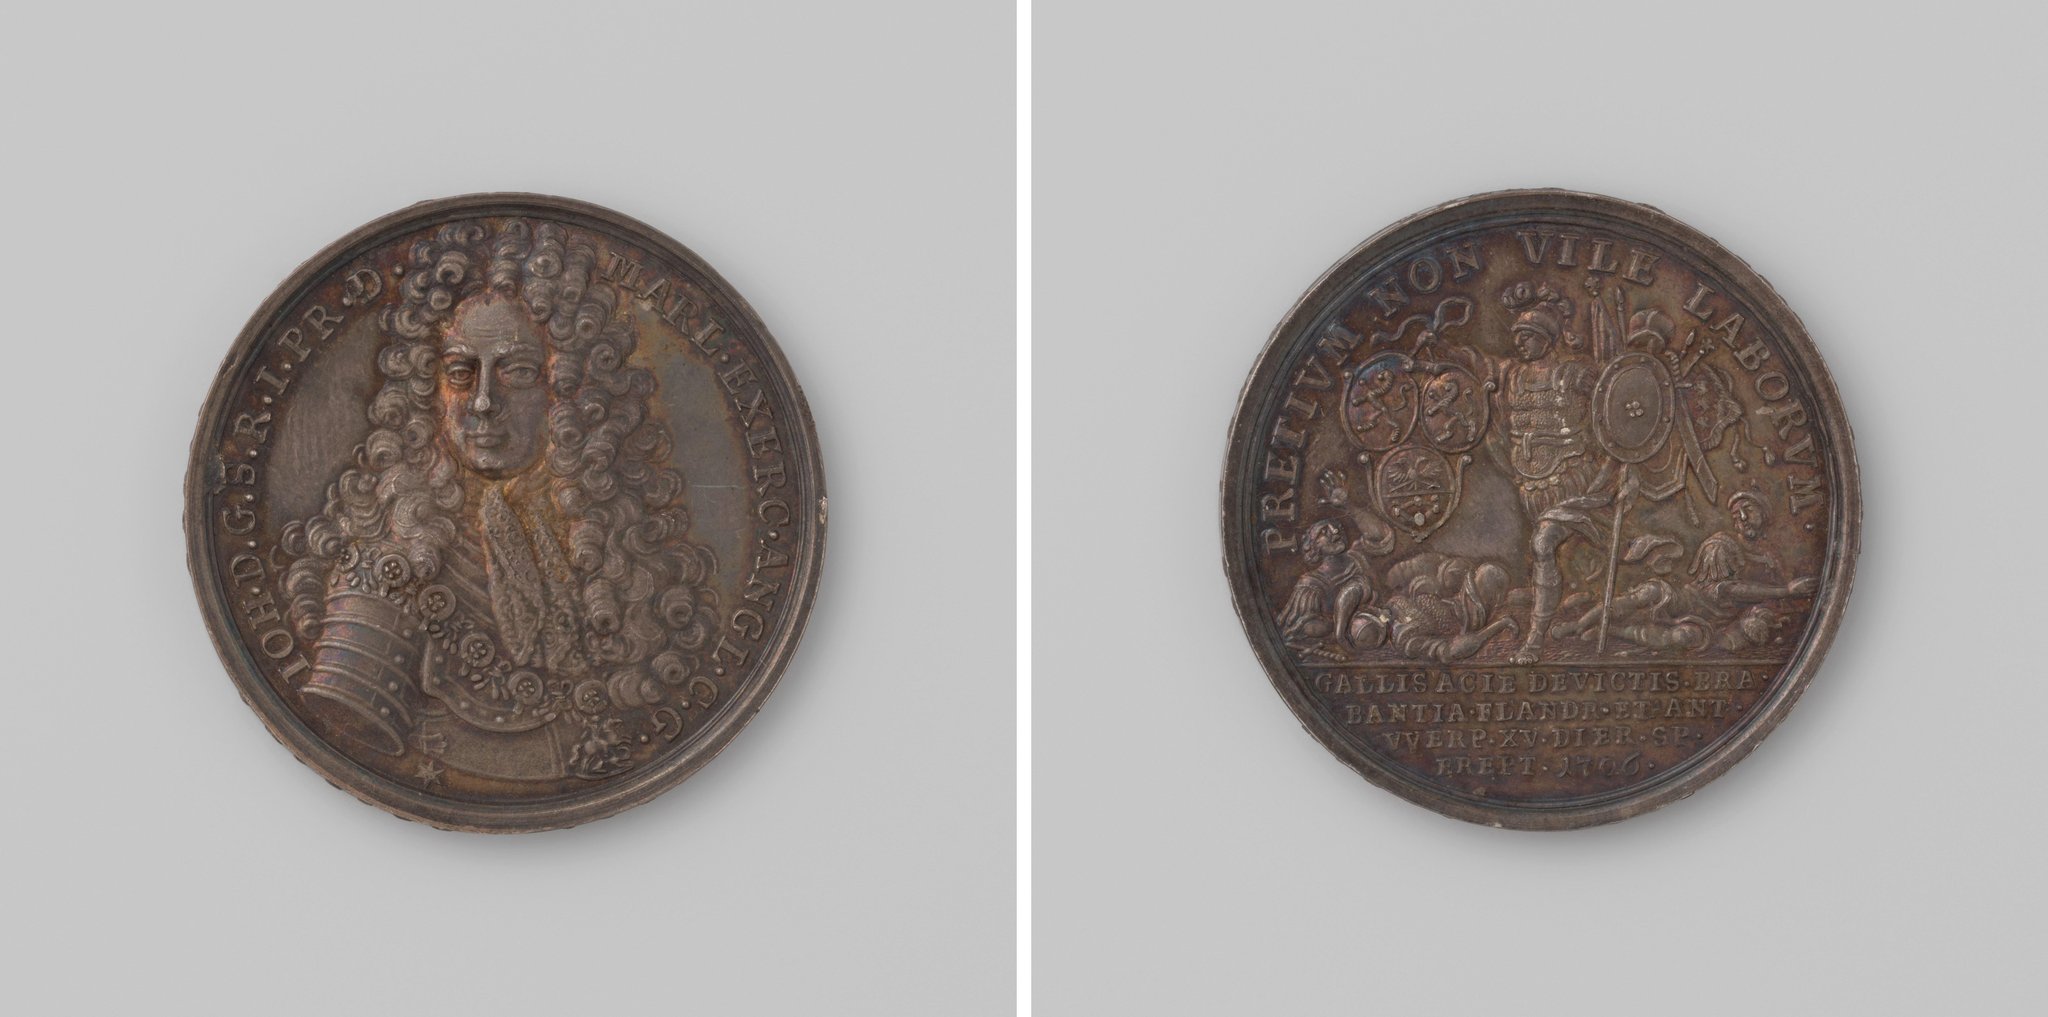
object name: history medal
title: Verovering van Brabant, Vlaanderen en Antwerpen in de twee weken volgend op de slag bij Ramillies, ter ere van de hertog van Marlborough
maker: georg hautsch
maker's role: medailleur, muntmaker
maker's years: 1679-1745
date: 1706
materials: silver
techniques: striking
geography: nuremberg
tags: john churchill (1e hertog van marlborough), antwerp, brabant